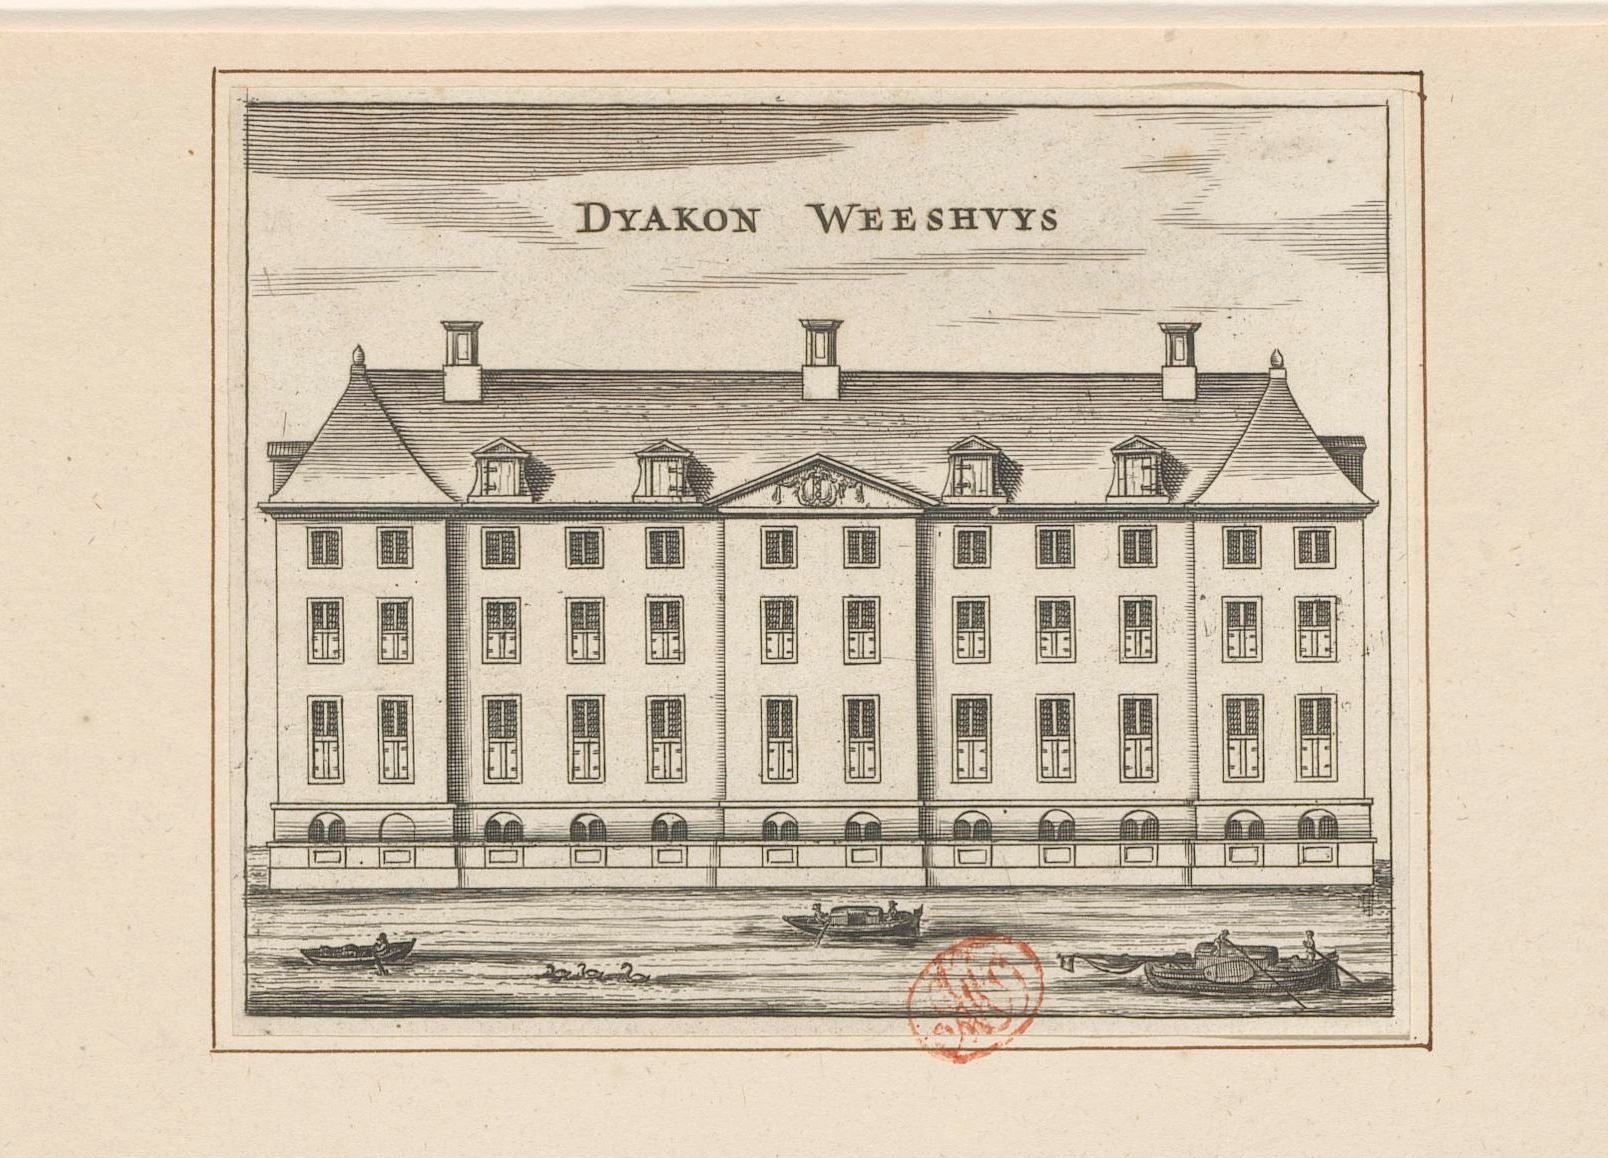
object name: print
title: Dyakon Weeshuys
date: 1664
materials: paper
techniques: engraving, etching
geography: amsterdam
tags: public welfare, orphanage, canals, waters (in city) (+ city(-scape) with figures, staffage)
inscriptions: collector's mark: Lugt 195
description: Huidige staat van prent ook gebruikt in: Fockens, Melchior. Beschrijving Der wijdt-vermaarde Koop-stadt Amstelredam, Van haar eerste beginselen, zedert den Jare 1203. oude Voorrechten, verscheyde Vergrootingenoude Voor-rechten, en verscheyde Vergrootingen (…). 3e druk. Amsterdam: Marcus Willemsz. Doornick, 1664. En in: Zesen, Philipp von. Beschrybung der Weidtberuhmde Kauf-Stadt Amstelredam / Beschreibung der Stadt Amsterdam darinnen von derselben ersten ursprunge bis auf gegenwartigen zustand (…). Amsterdam: Marcus Willemsz. Doornick, 1664. Eerste bekende staat van prent (linksboven genummerd: 266) ook gebruikt in: Fockens, Melchior. Beschrijvinge Der wijdt-vermaarde Koop-stadt Amstelredam, Van hare eerste beginselen, oude Voor-rechten, en verscheyde Vergrootingen (…). 1e druk. Amsterdam: Marcus Willemsz. Doornick, 1662. En in: Fockens, Melchior. Beschrijvinge Der wijdt-vermaarde Koop-stadt Amstelredam, Van hare eerste beginselen, oude Voor-rechten, en verscheyde Vergrootingen (…). 2e druk. Amsterdam: Marcus Willemsz. Doornick, 1662. Derde bekende staat (met toevoeging Franse titel) mogelijk ook gebruikt in: Domselaer, Tobias en Isaac Commelin. Beschryvinge van Amsterdam : haar eerste oorspronk uyt den huyze der heeren van Aemstel en Aemstellant (…). 6 delen. Amsterdam: Marcus Willemsz van Doornick, 1665. Vierde bekende staat (rechtsboven genummerd: 30) ook gebruikt in verschillende latere zeventiende- en achttiende-eeuwse publicaties.